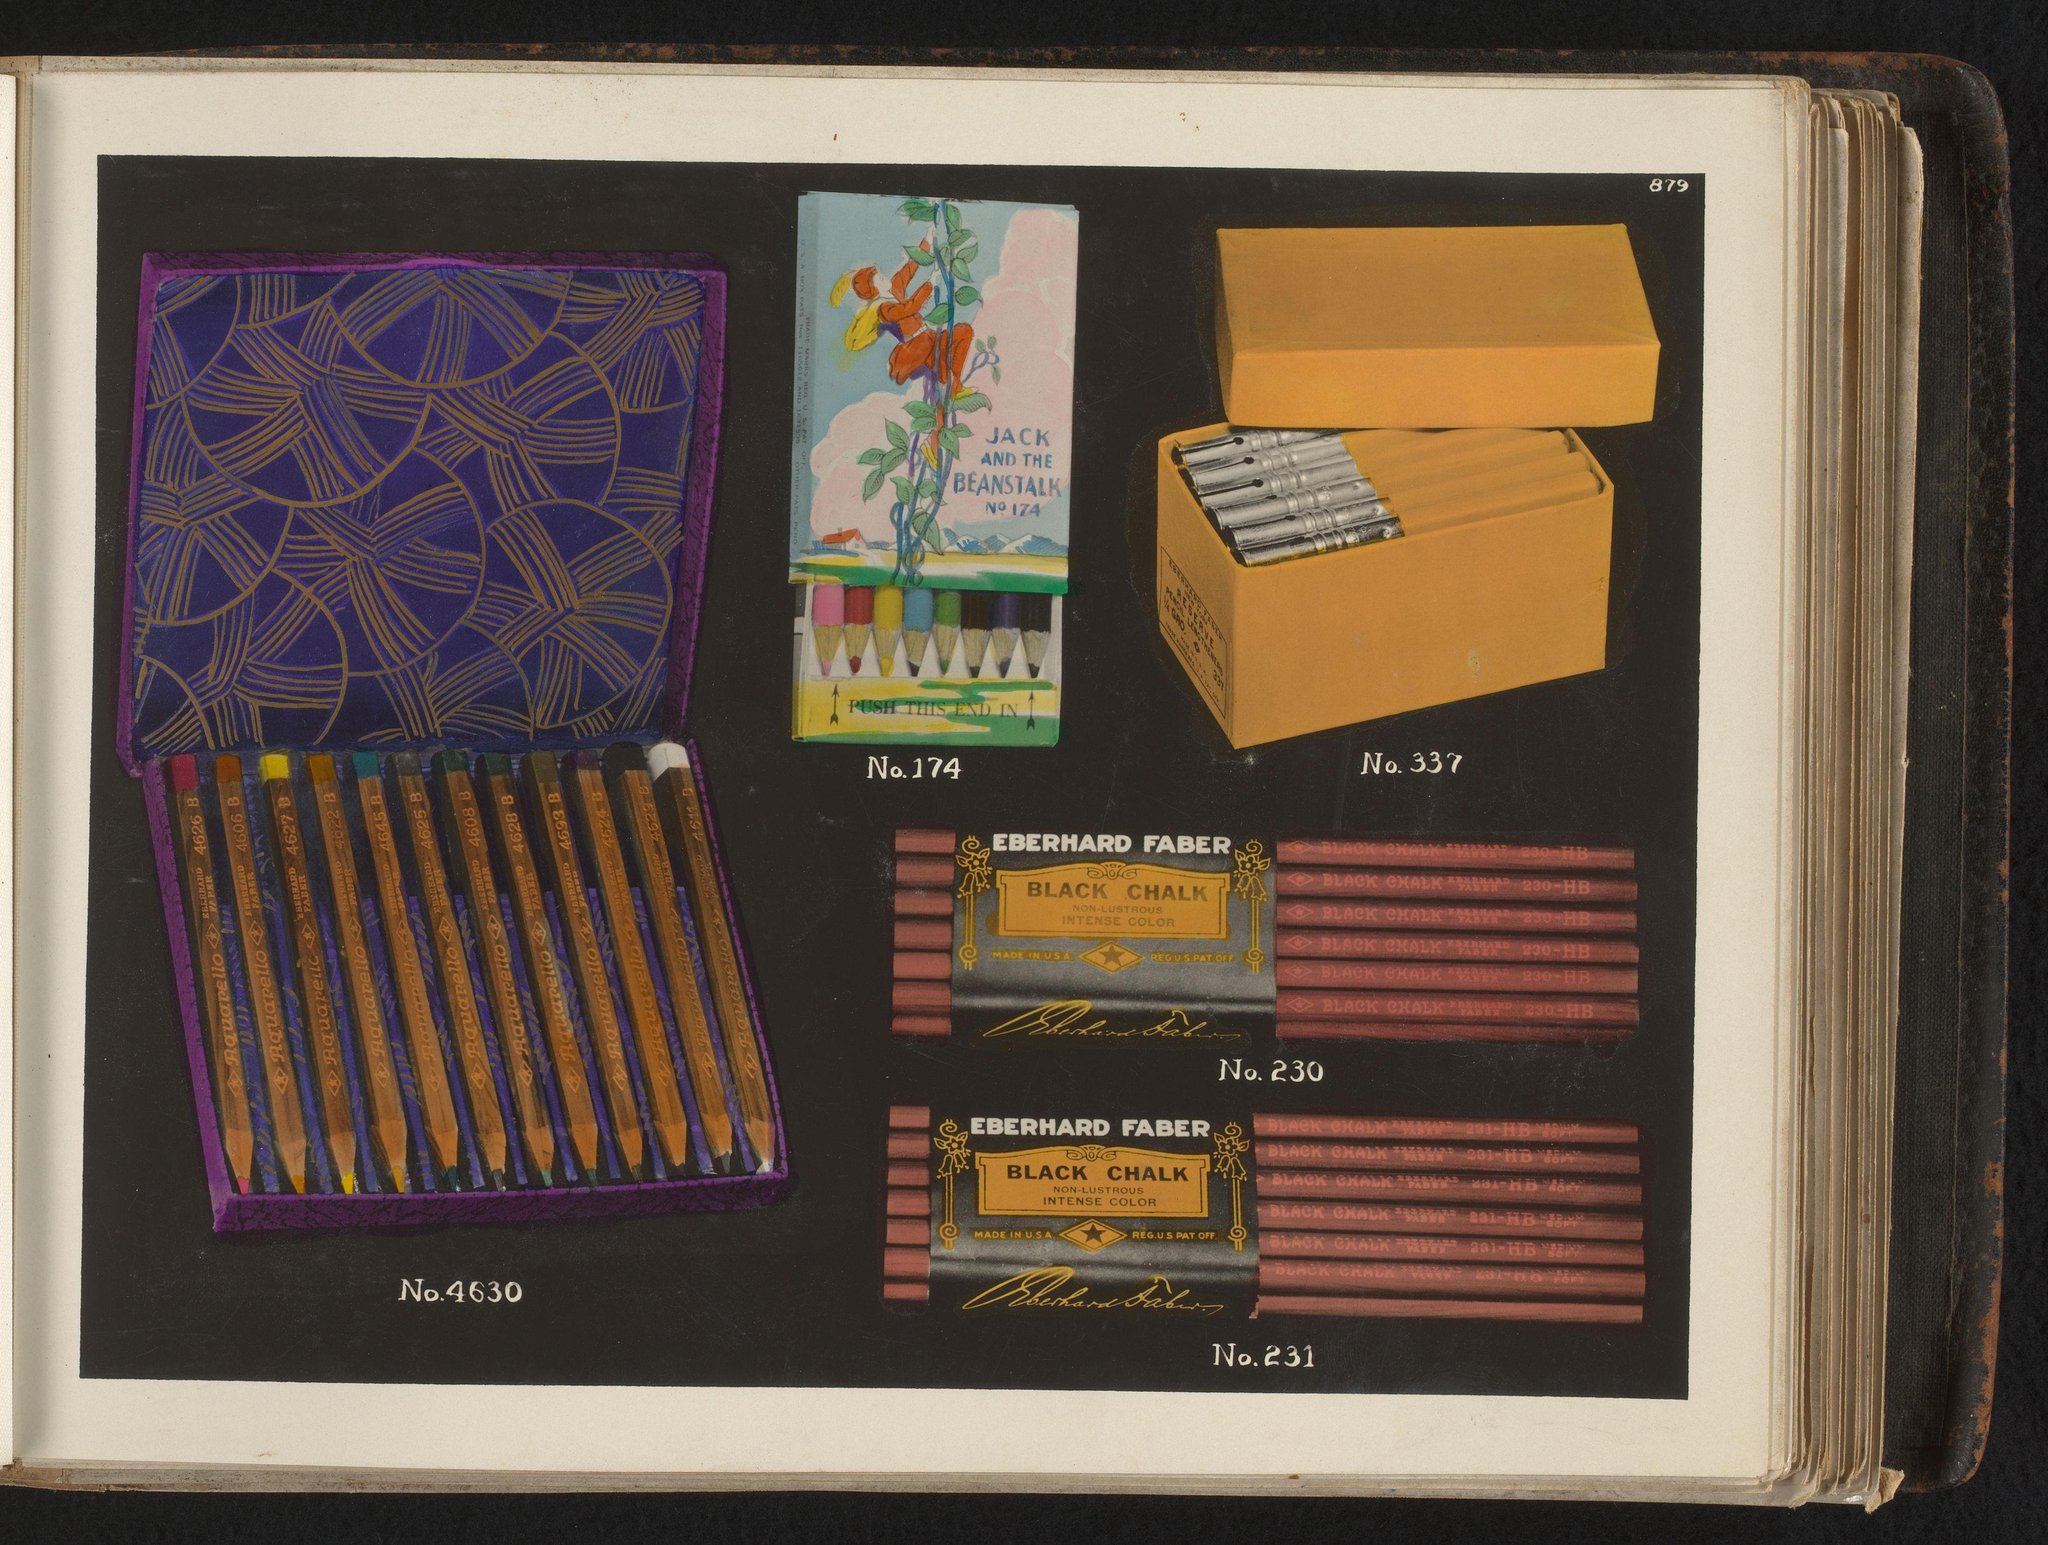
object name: album leaf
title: Sets met potloden van Eberhard Faber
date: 1915-1935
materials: paper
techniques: gelatin silver print, hand coloring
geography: springfield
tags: pencil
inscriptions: number: ‘879’, stamp: ‘Paramount/ Commercial Studios/ 145 Chestnut St./ Springfield - Mass.’